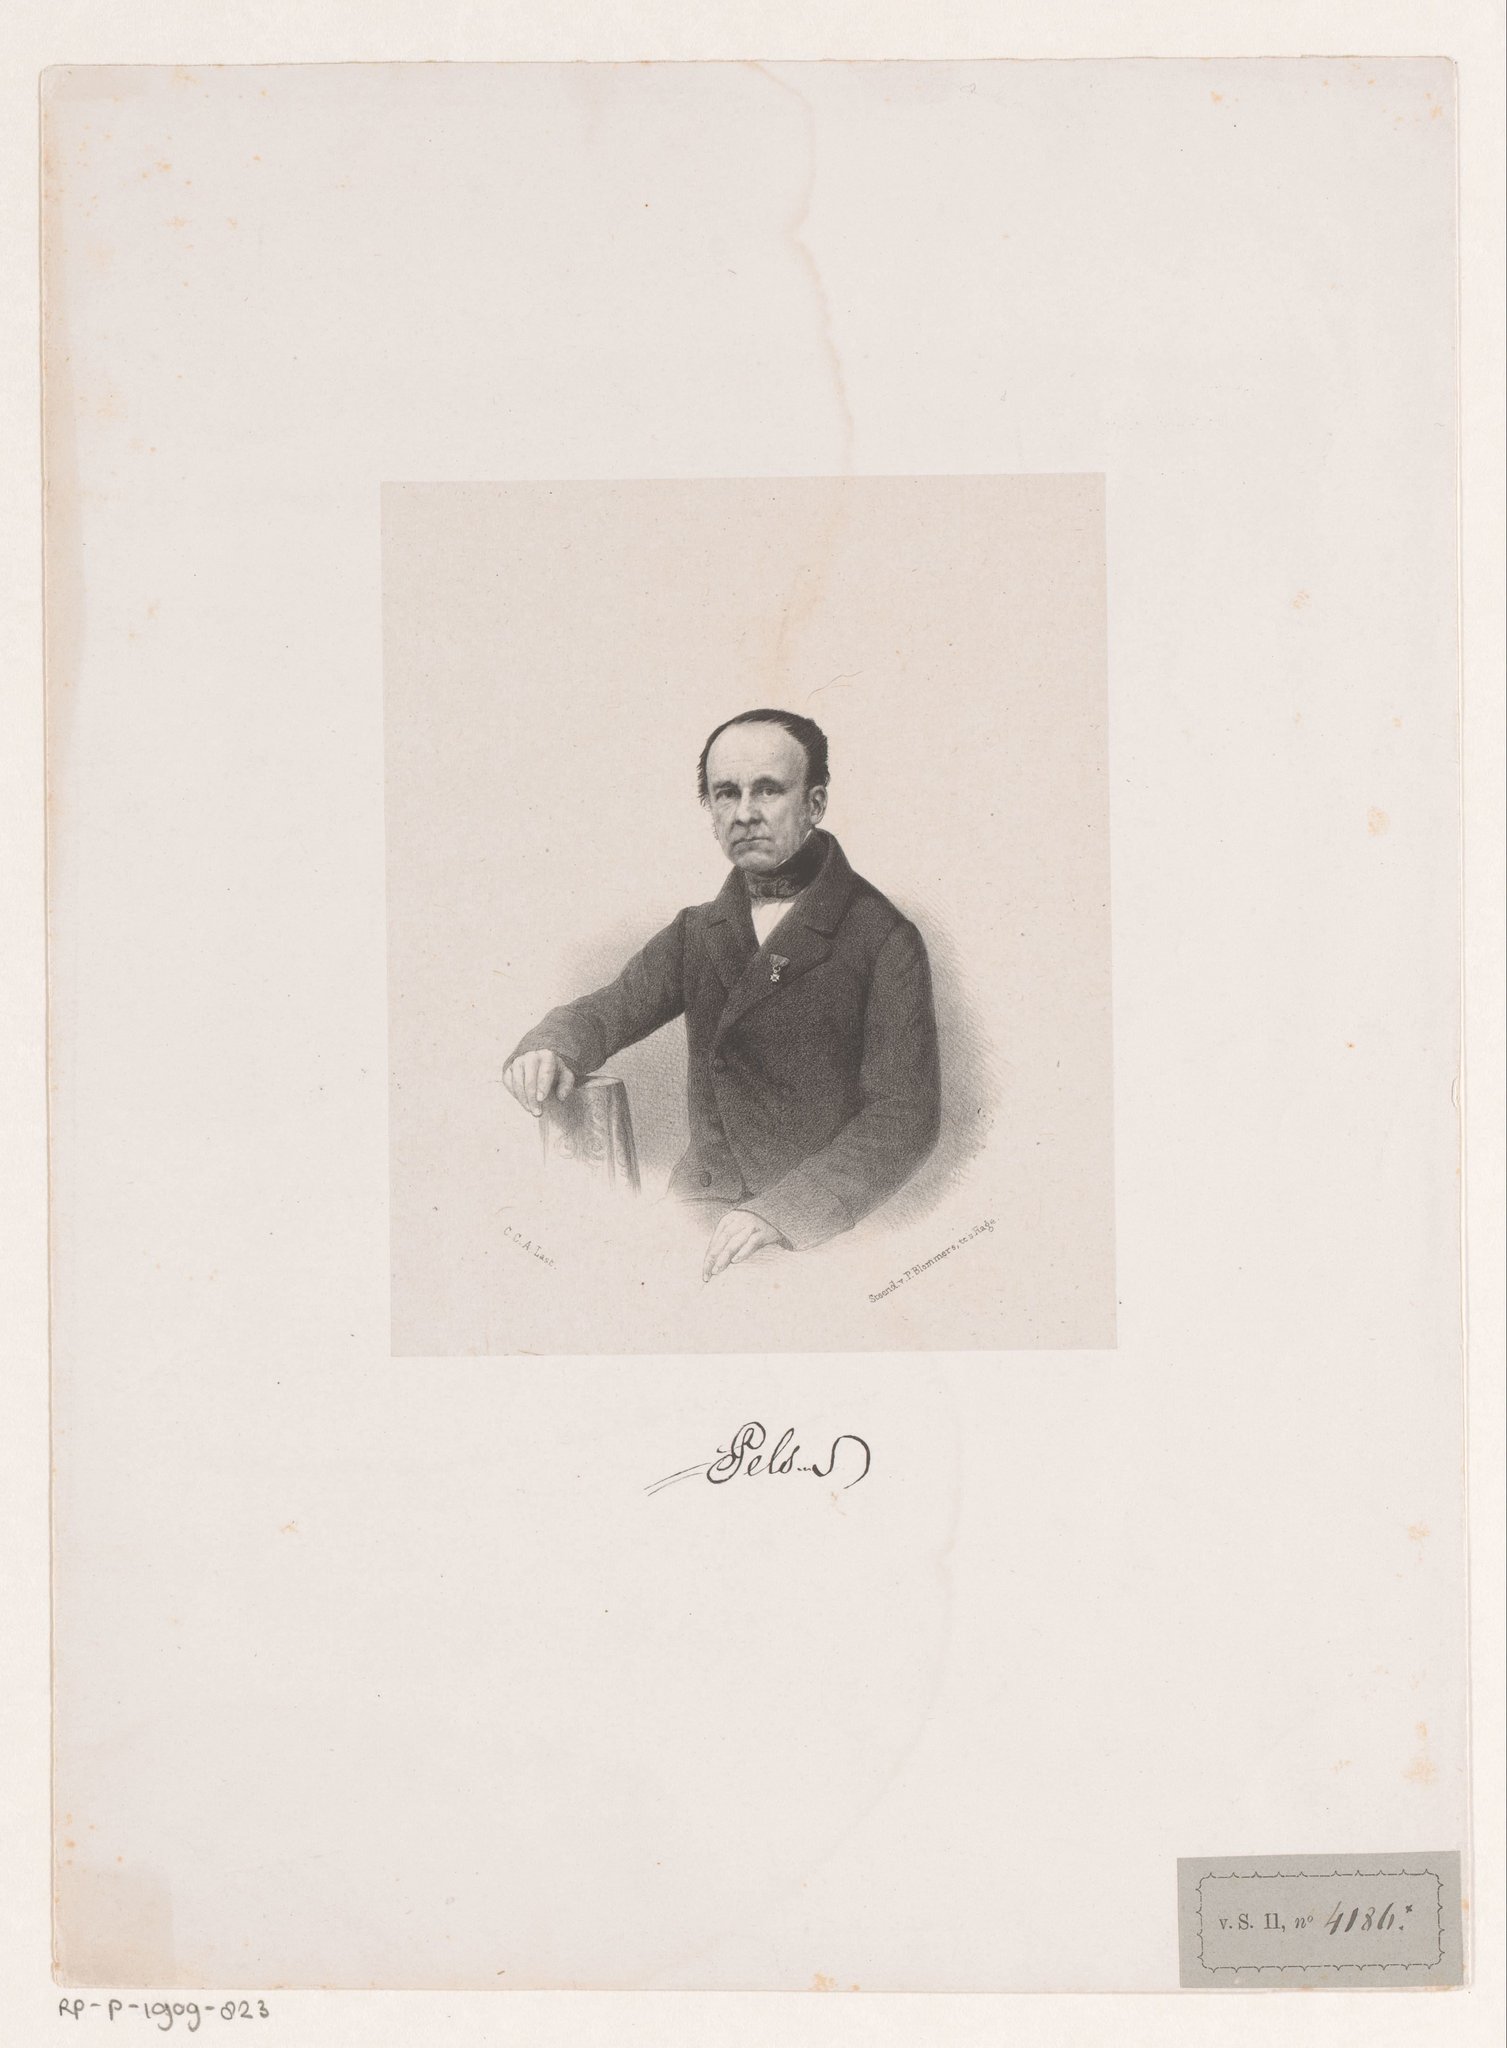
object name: print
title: Portret van de heer Pels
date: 1842-1887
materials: paper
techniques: lithograph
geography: the hague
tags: historical persons (+ (full) bust portrait)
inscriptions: collector's mark: Lugt 2228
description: Onder het portret de signatuur van de geportretteerde.